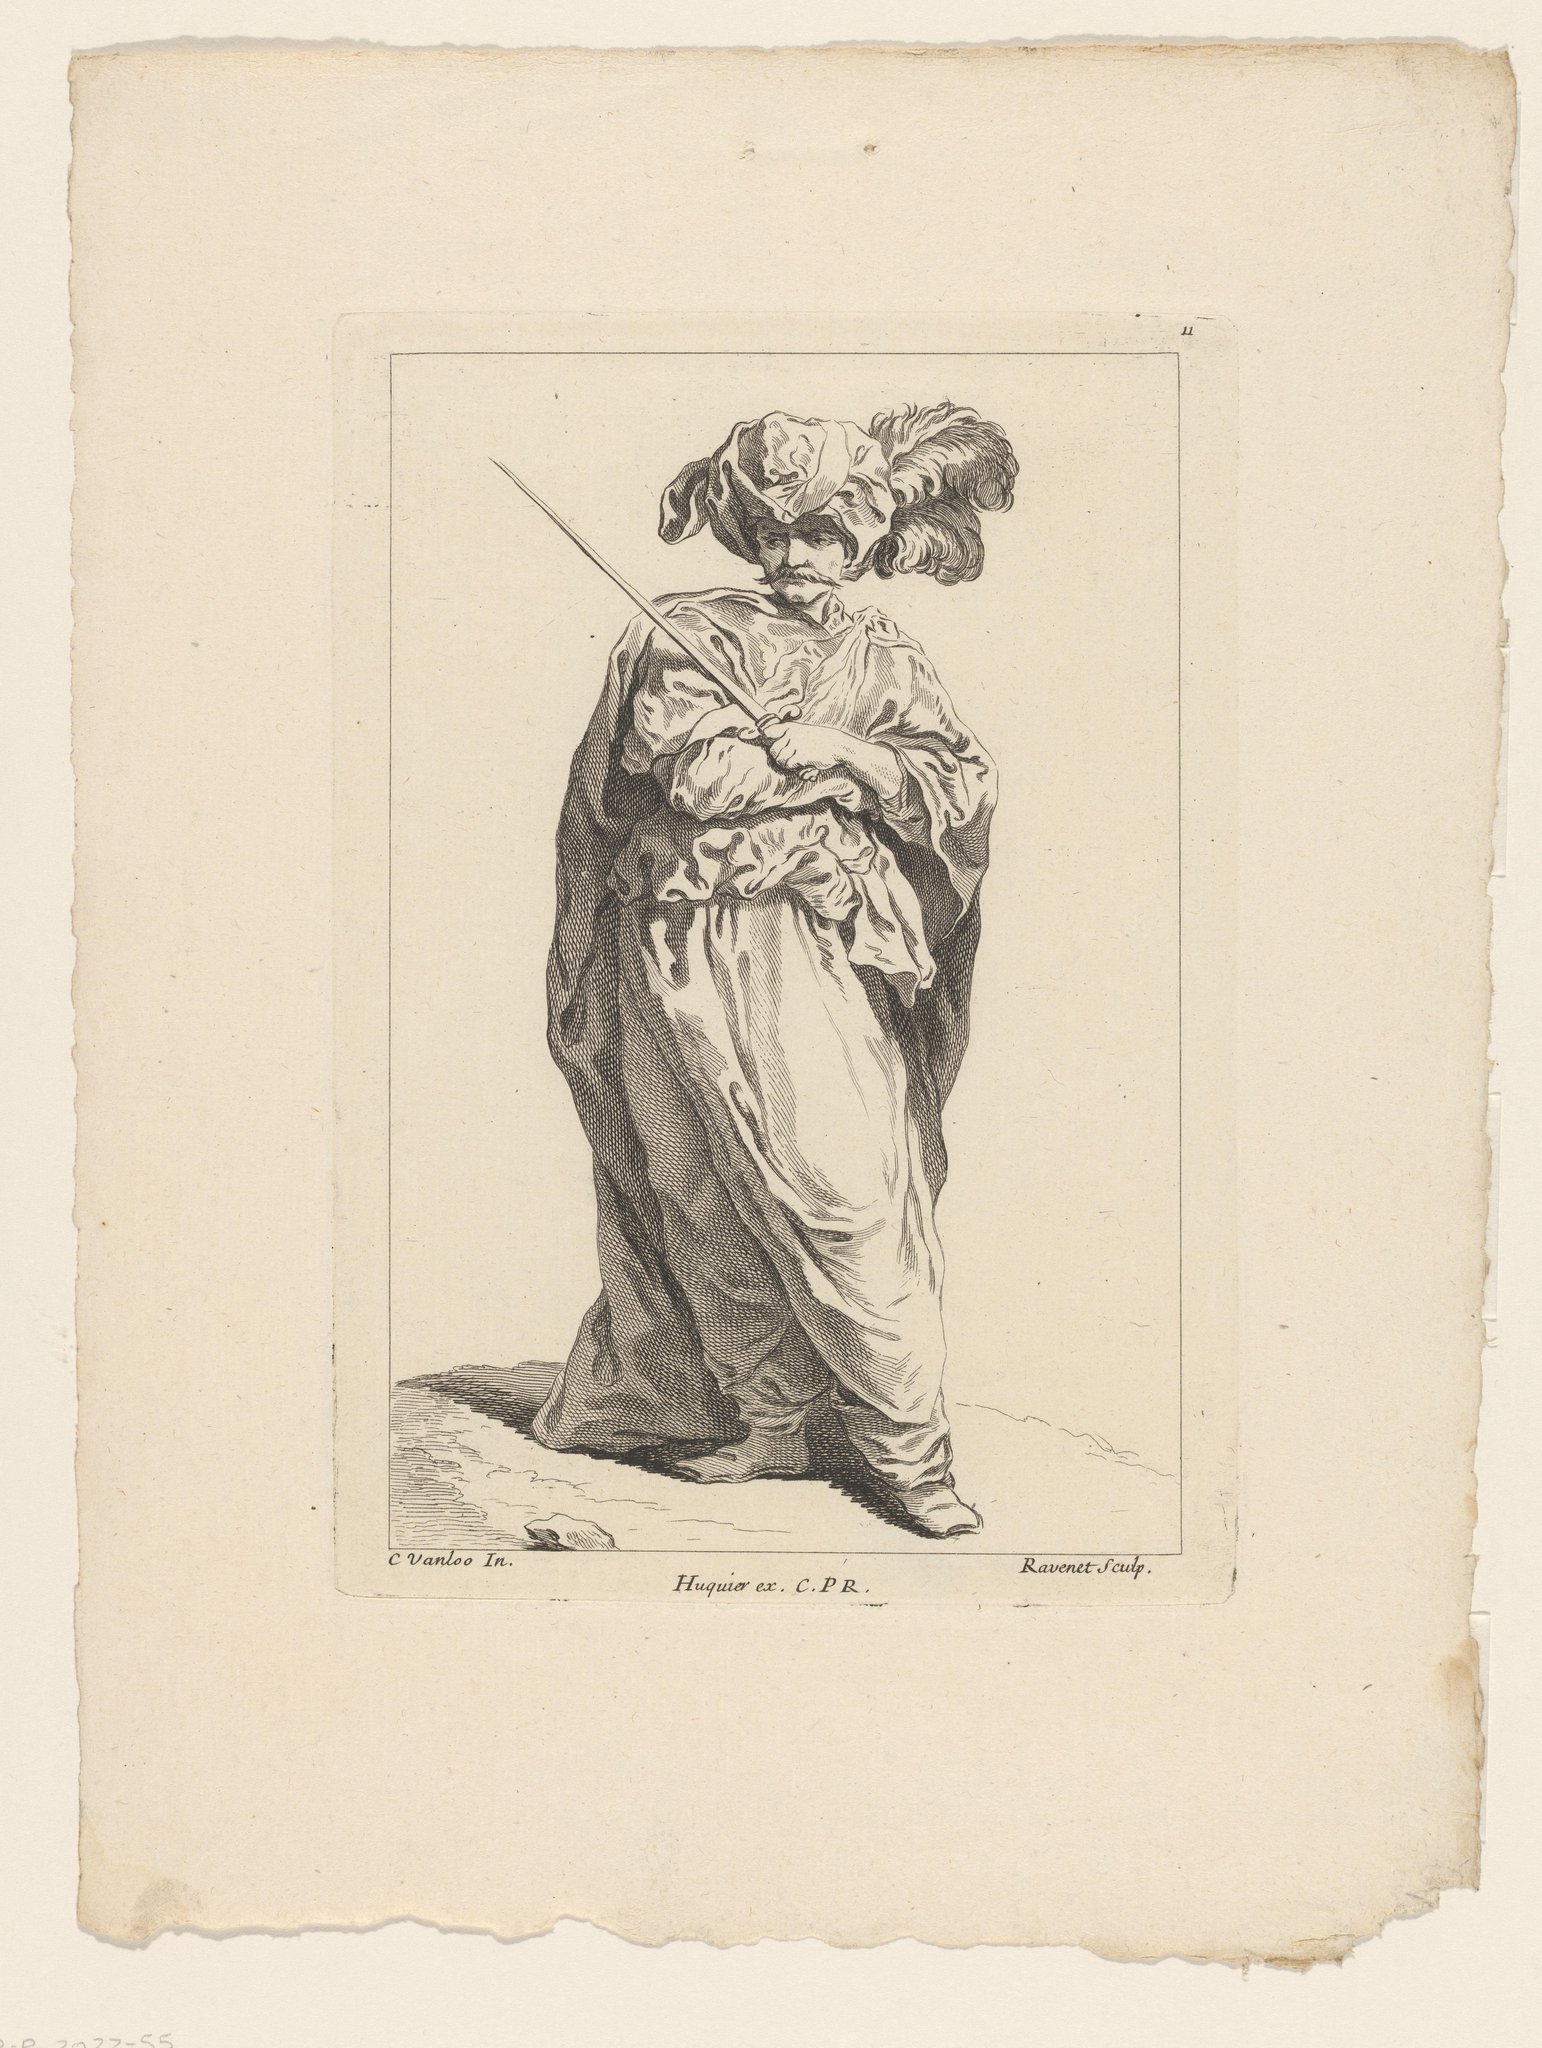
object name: print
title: Verzameling van verschillende gedramatiseerde poses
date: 1732-1740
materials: paper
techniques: etching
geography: rome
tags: passions, emotions, affections, asiatic races and peoples (+ costume), head-gear: turban, characters (human types), actor (on the stage)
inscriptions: collector's mark: Lugt 2760, collector's mark: Lugt 2228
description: Staande figuur met tulband met veren, lange mantel en degen in de hand. Rechtsboven genummerd: 11. Onderdeel van een serie van twaalf prenten met figuren in gedramatiseerde poses, veelal gekleed in ‘Oosterse’ fantasiekostuums, naar tekeningen van Carle van Loo, gemaakt tijdens zijn verblijf in Rome (1728-1732).